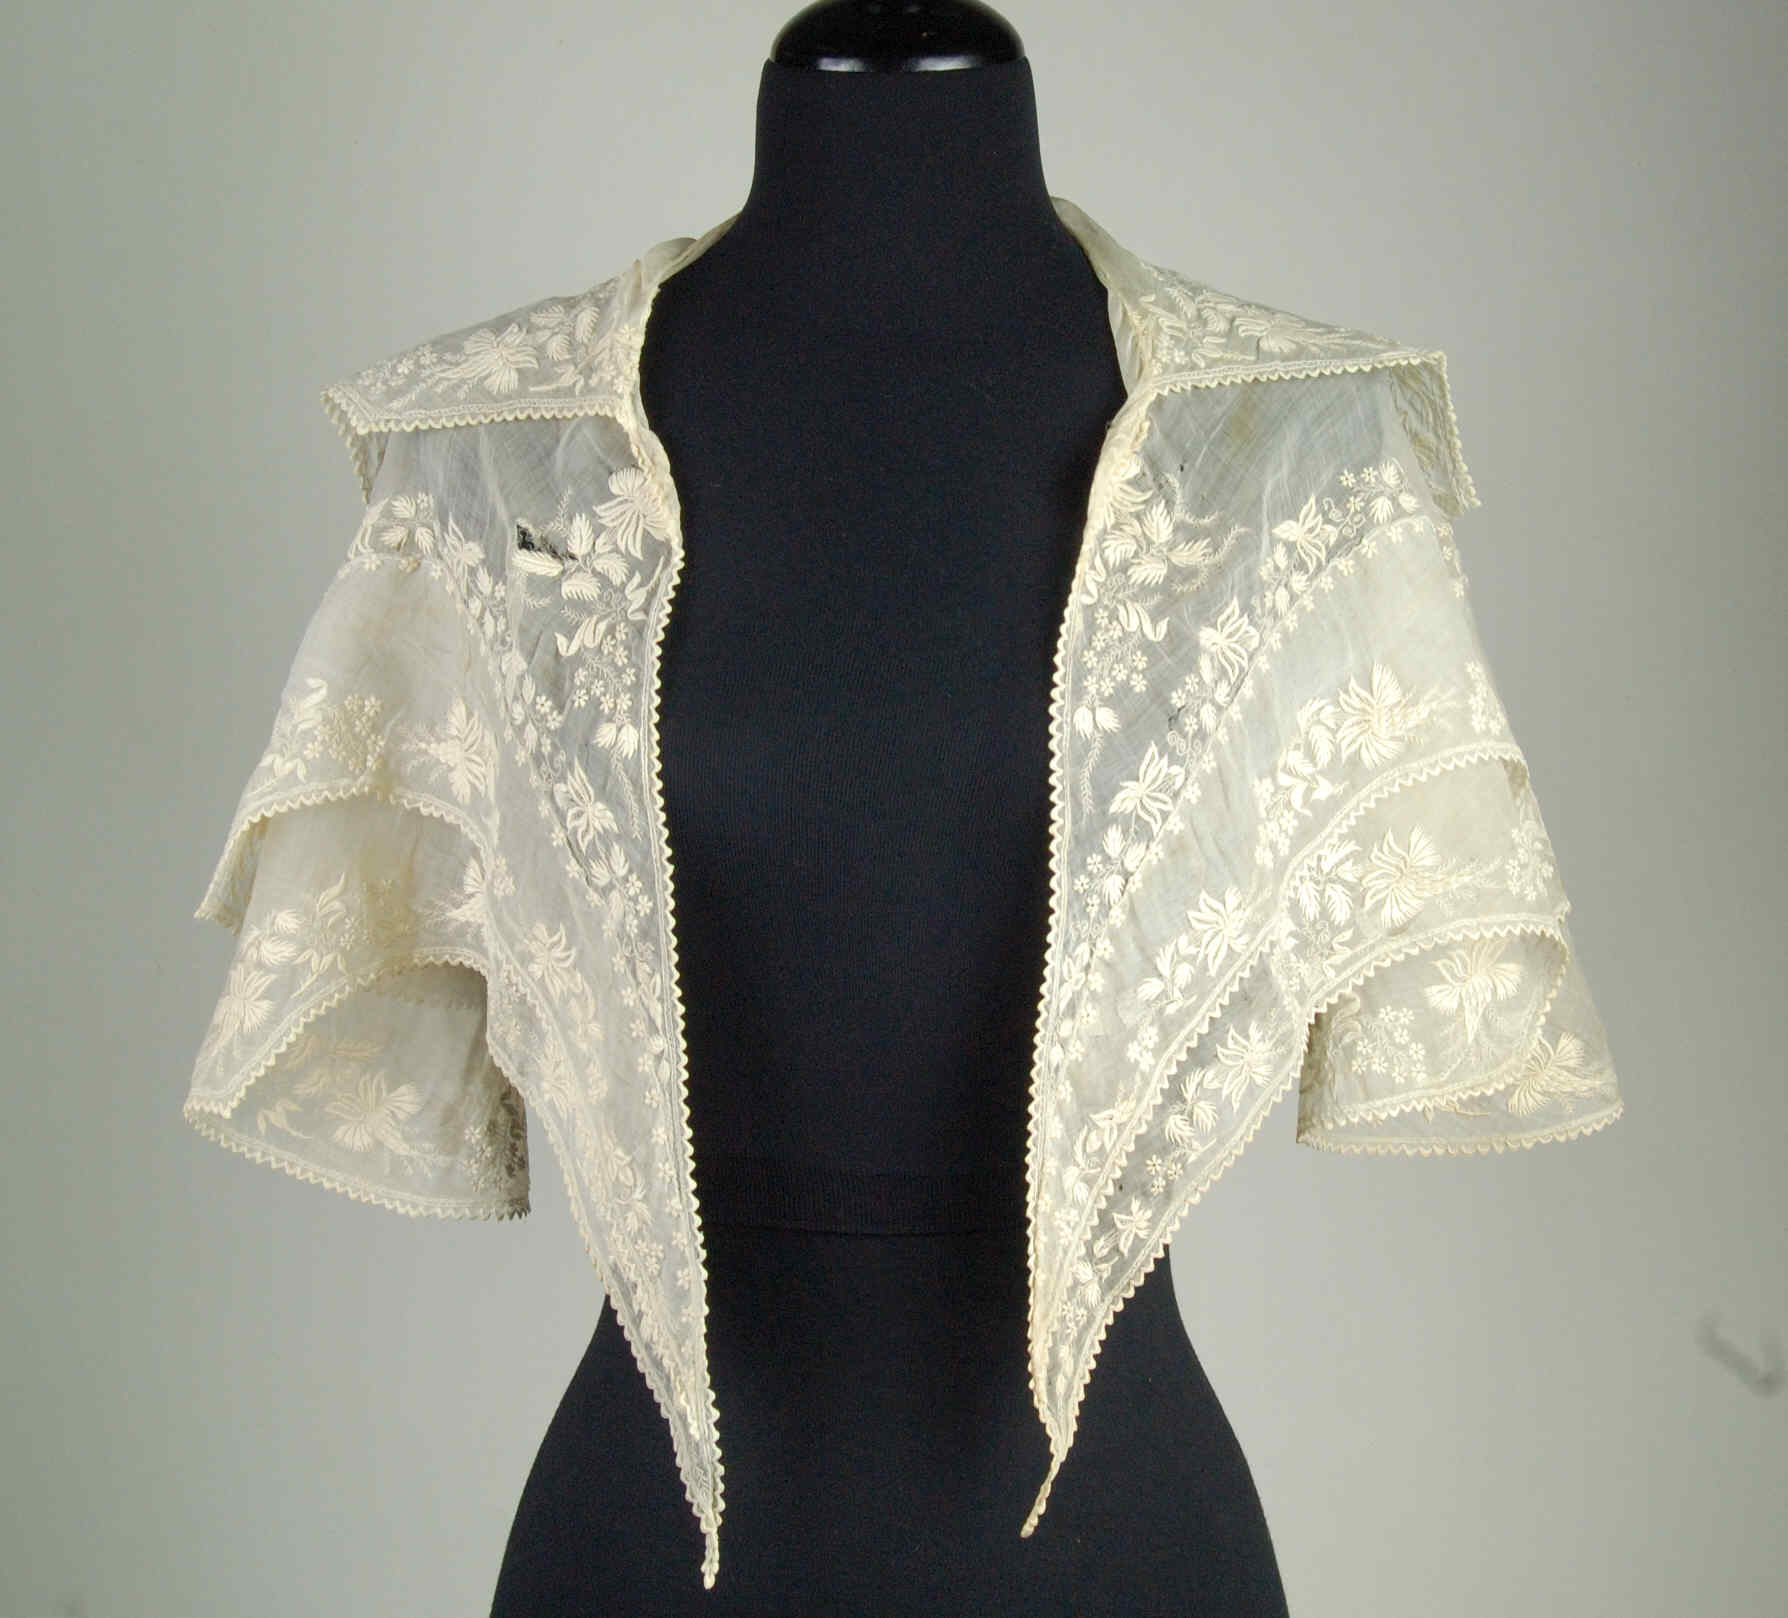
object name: pelerine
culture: american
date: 1835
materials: cotton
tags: flowers